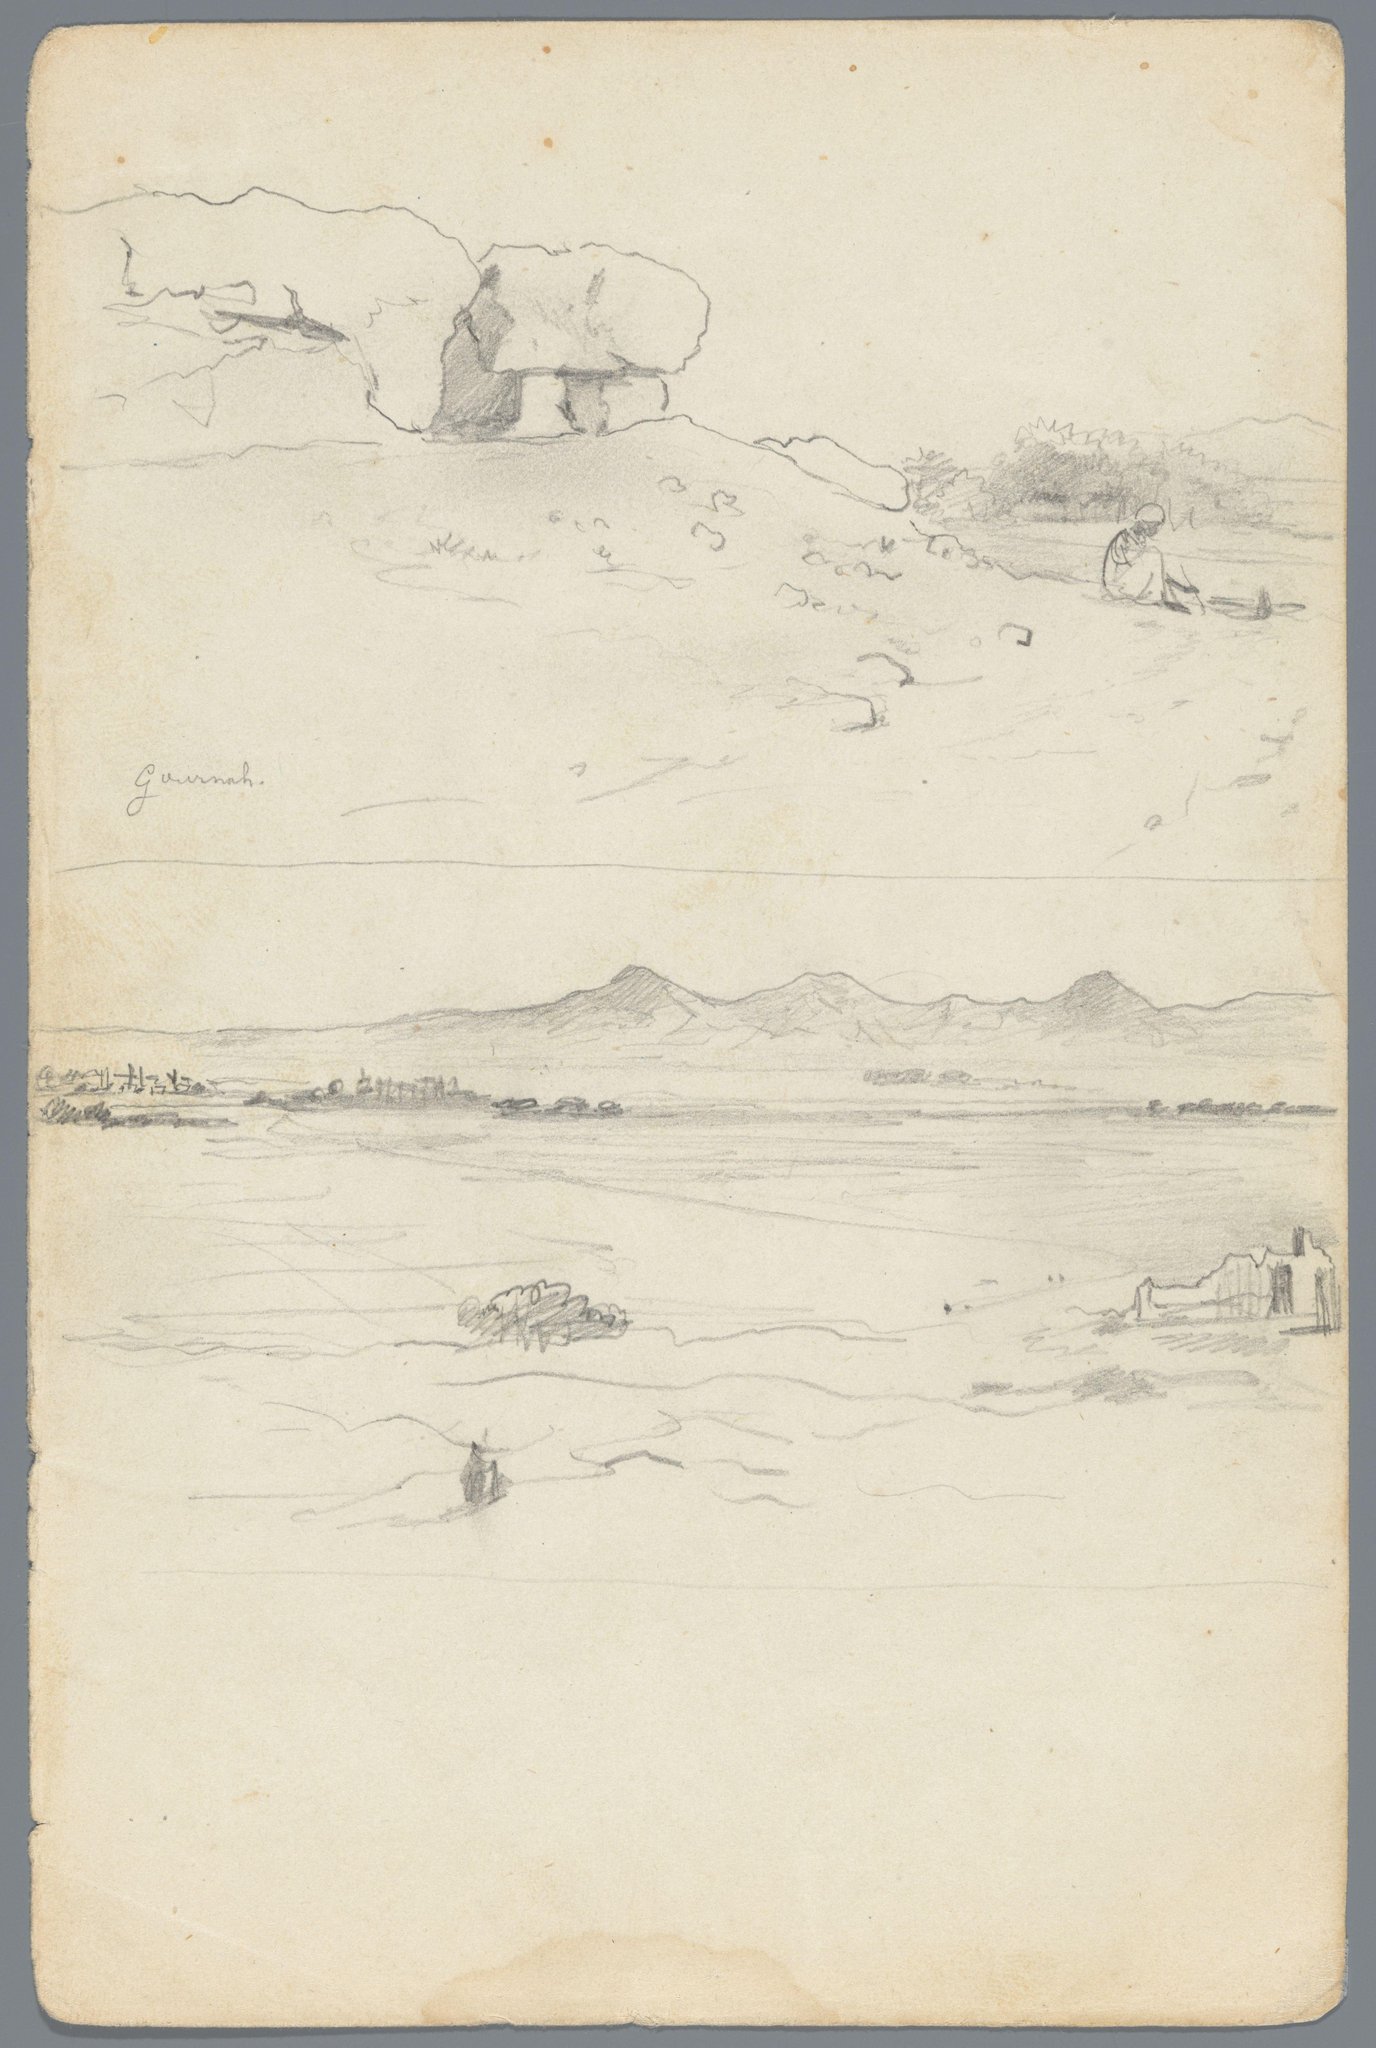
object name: sketchbook leaf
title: Twee landschappen, waarbij Gournah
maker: willem de famars testas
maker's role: draughtsman, painter, print maker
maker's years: 1834-1896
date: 1858-1859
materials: pencil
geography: egypt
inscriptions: inscription: ‘Gournah’